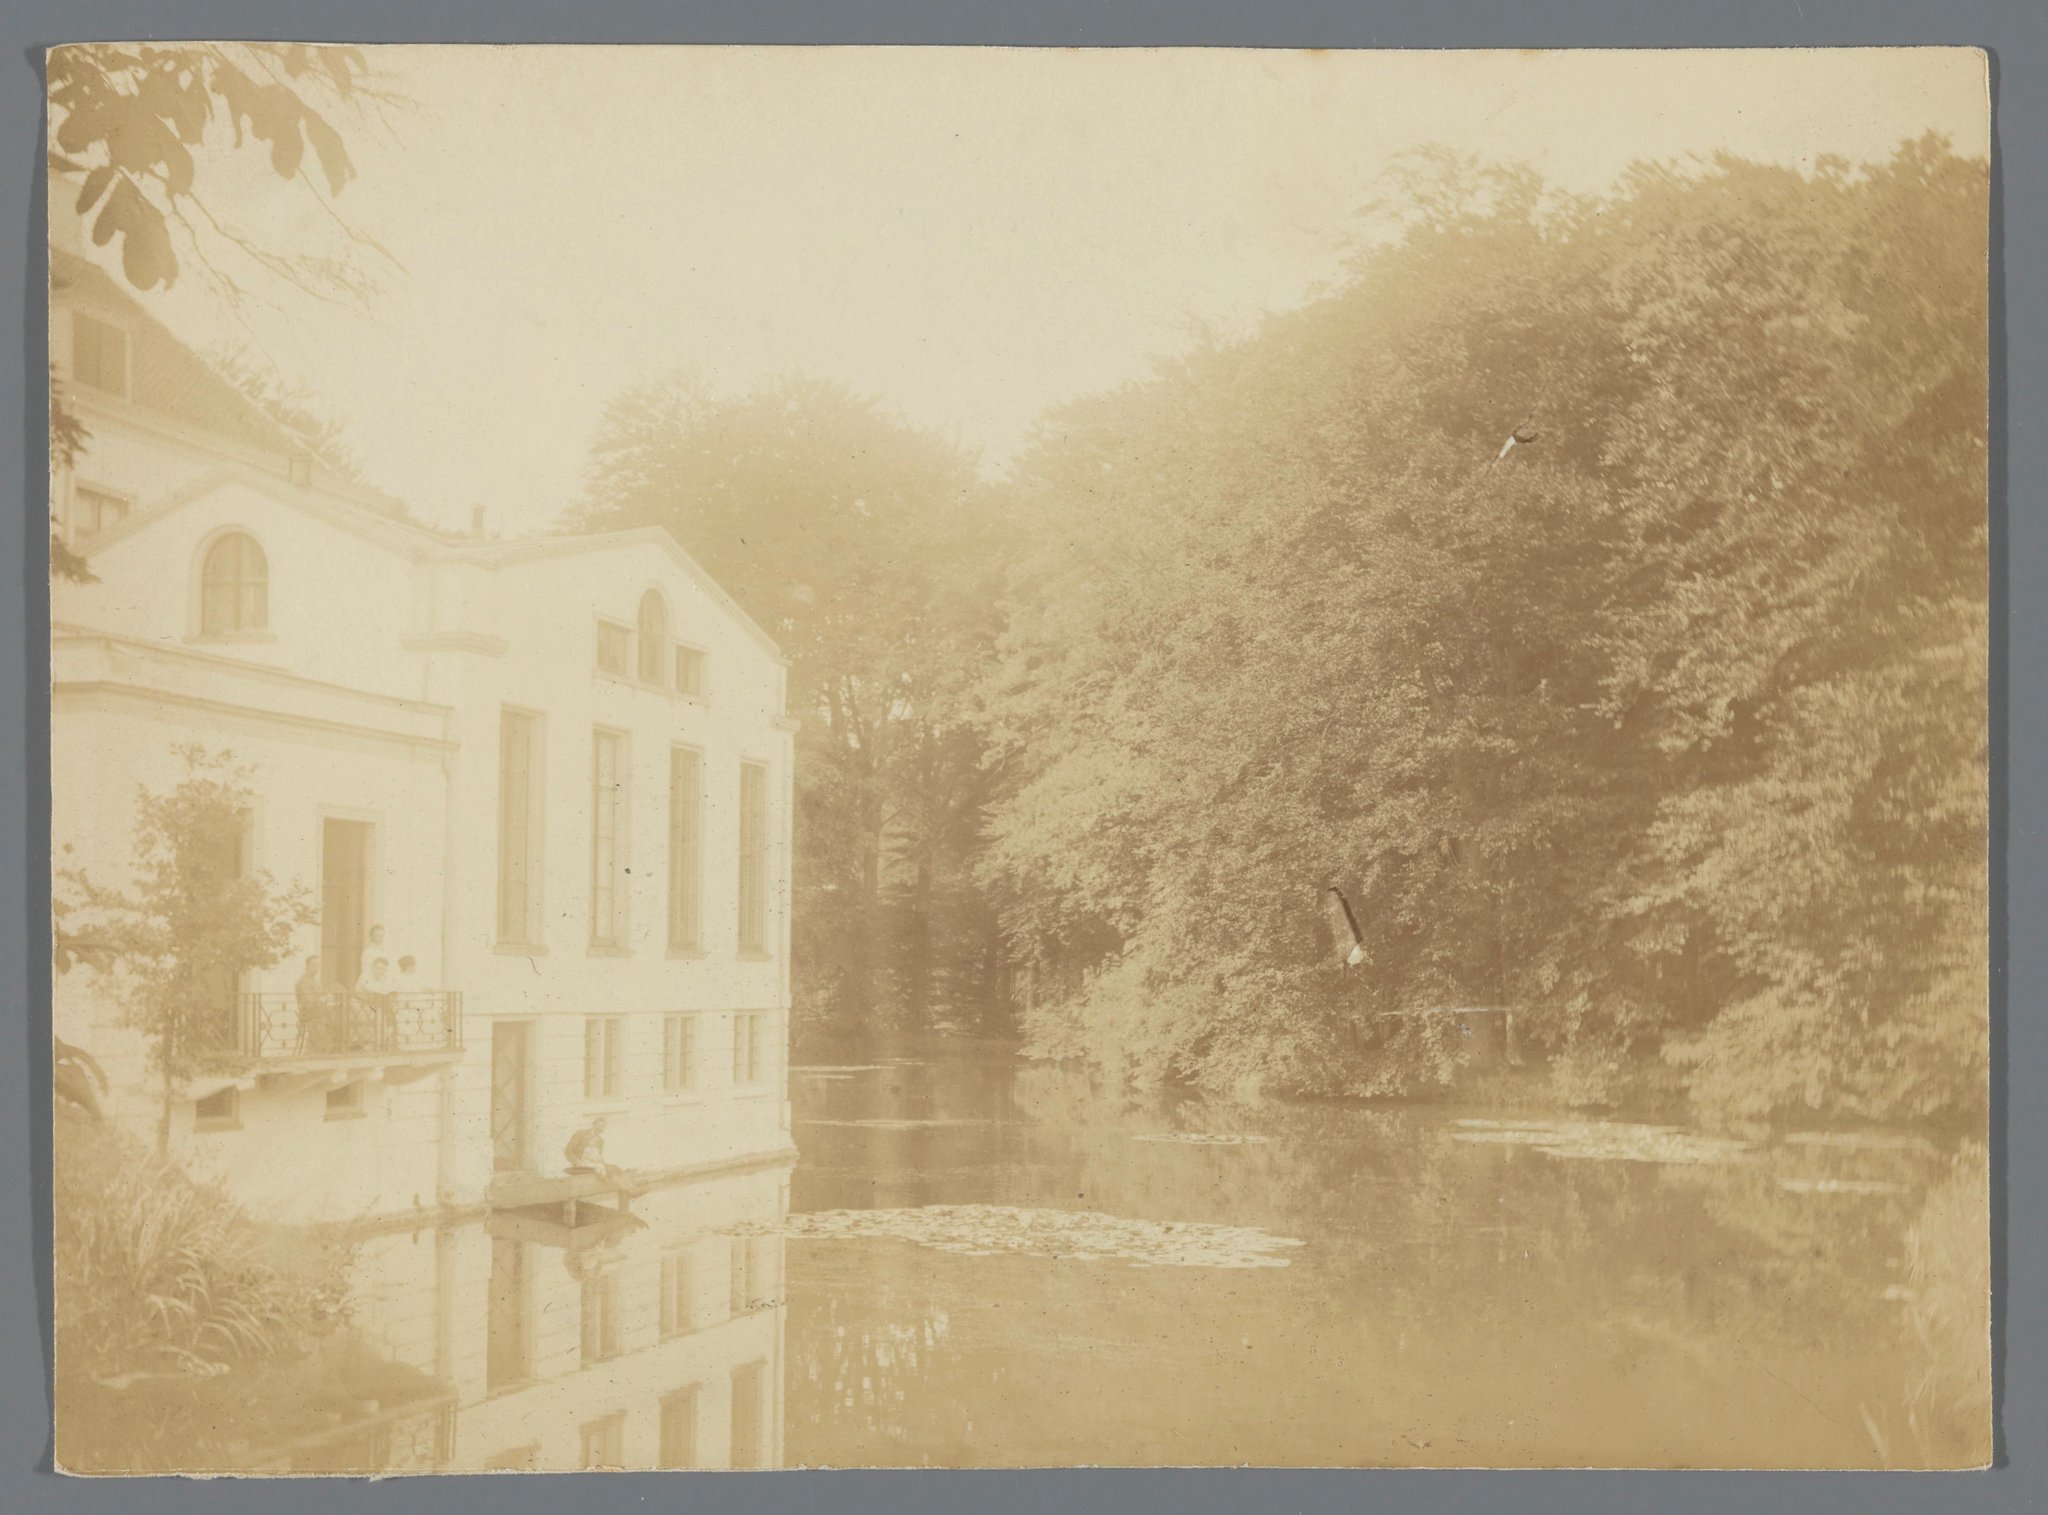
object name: photograph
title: Gezicht op een landhuis aan het water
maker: cornelia hendrika jonker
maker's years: 1874-1924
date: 1880-1920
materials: photographic support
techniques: collodion silver print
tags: historical persons, rural housing, e.g. country-house, villa, cottage